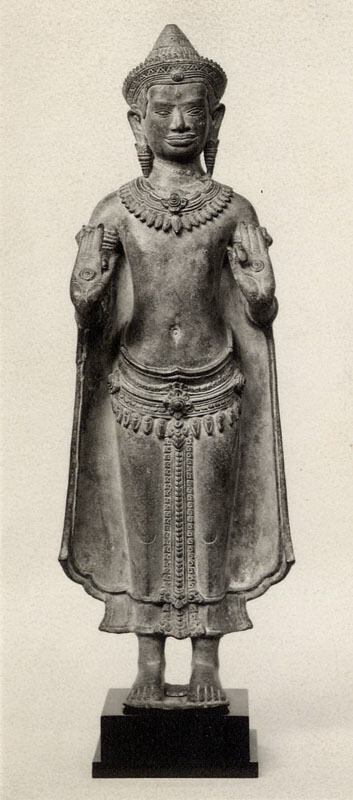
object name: figure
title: Standing Buddha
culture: thai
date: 1101-1200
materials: bronze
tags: buddhism,buddha